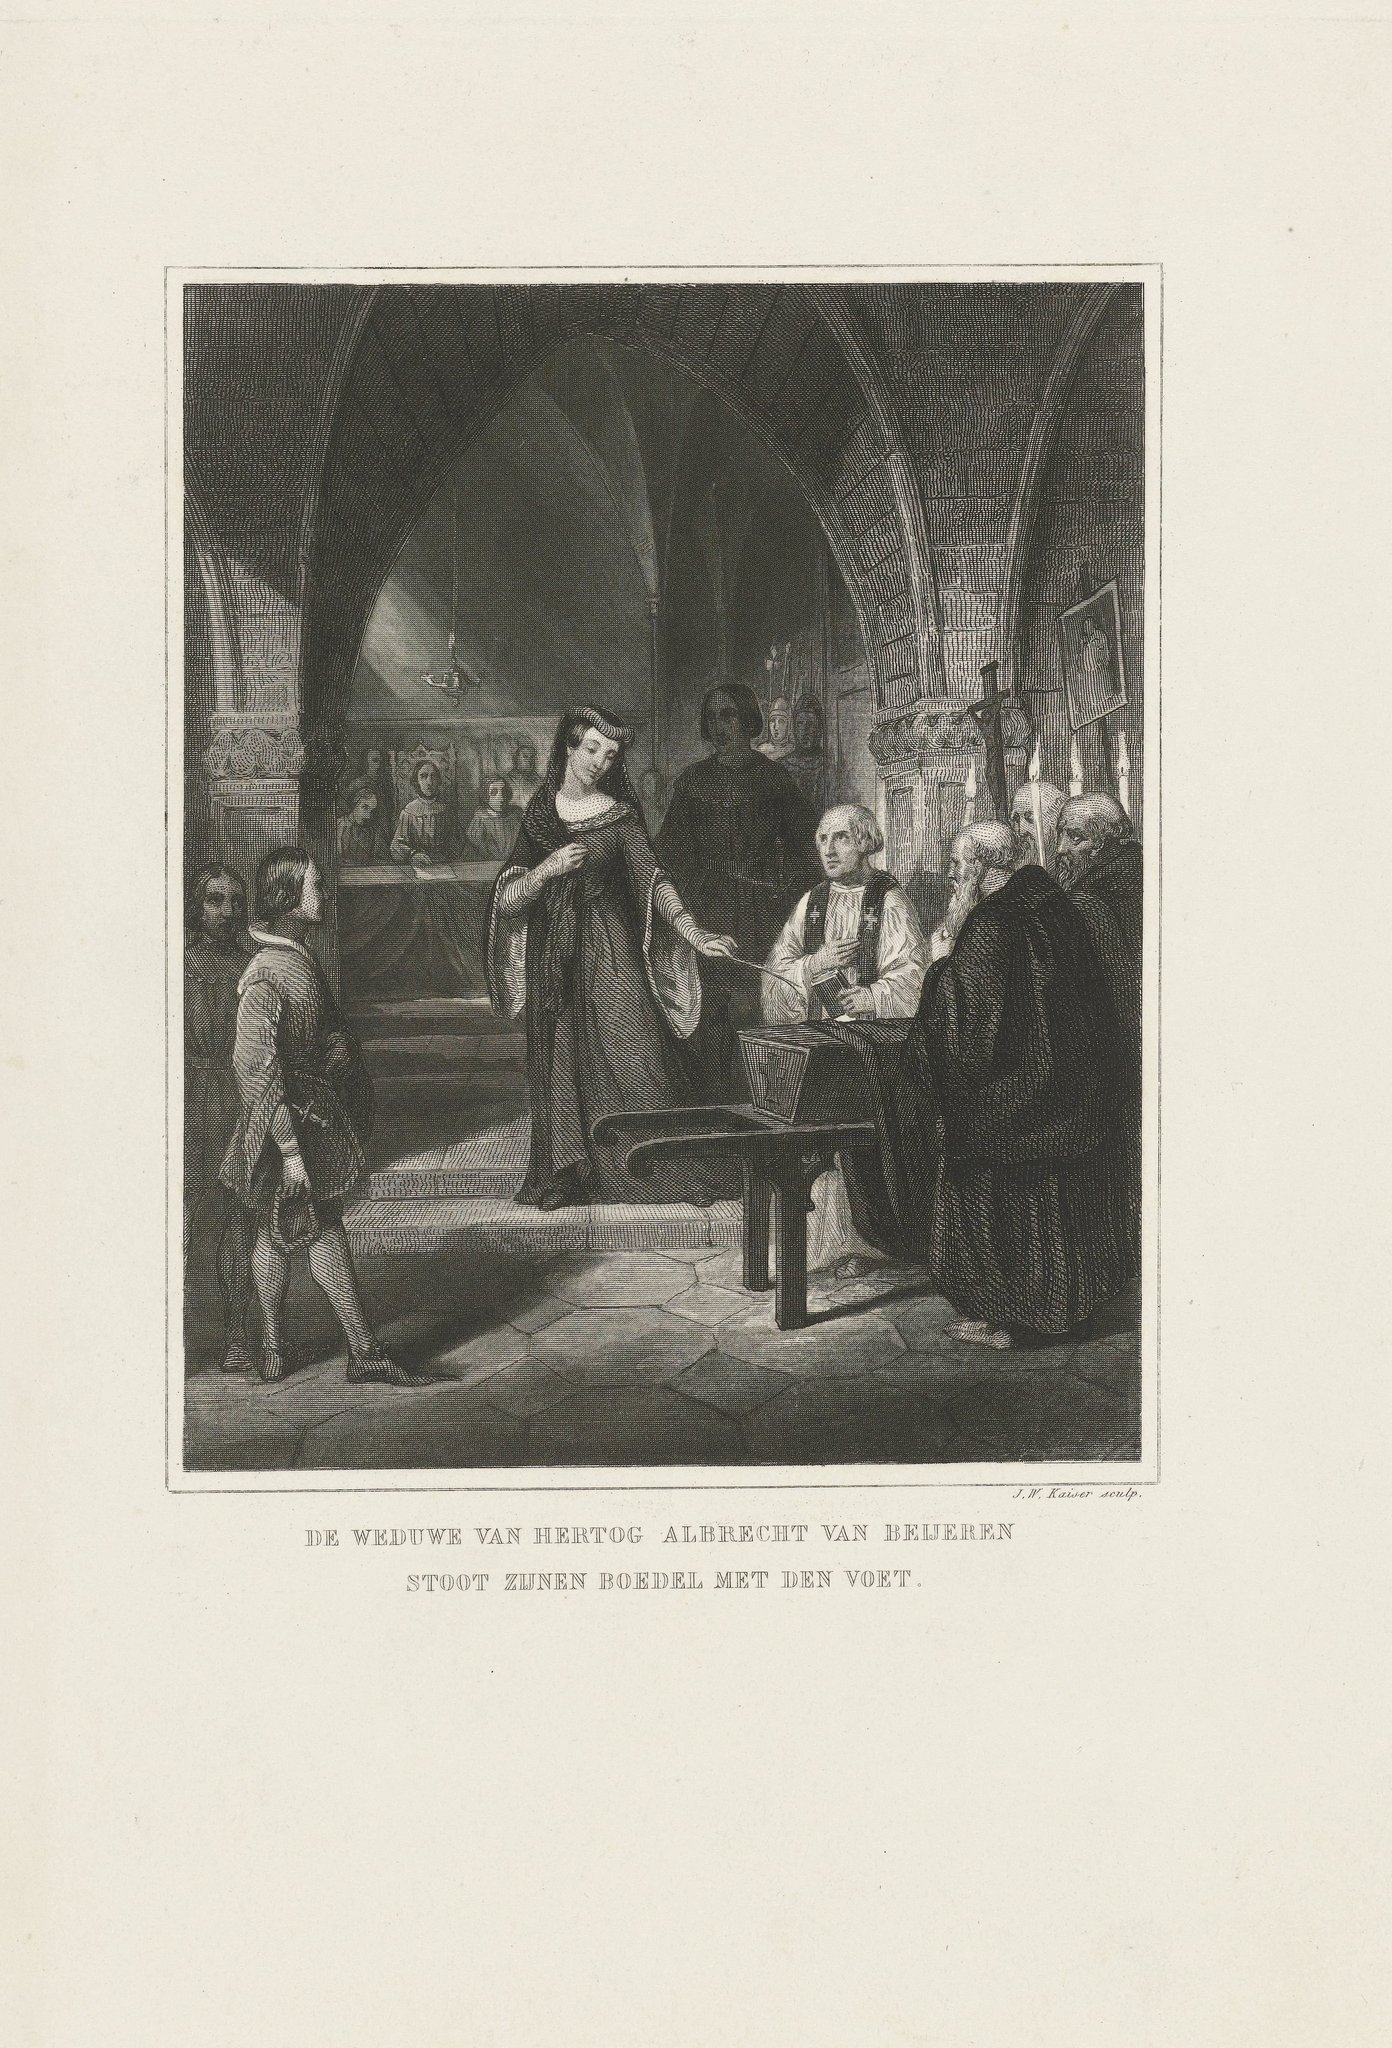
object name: print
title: De weduwe van hertog Albrecht van Beijeren stoot zijnen boedel met den voet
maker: johann wilhelm kaiser (i)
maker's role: draughtsman, print maker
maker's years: 1813-1900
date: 1840-1884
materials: paper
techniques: engraving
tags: the hague, duke of bavaria albert i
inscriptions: collector's mark: Lugt 2228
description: In een interieur staat de doodskist van Albrecht van Beieren. Zijn weduwe Margaretha van Kleef raakt, in het bijzijn van een aantal geestelijken, de kist aan met een takje. Hiermee doet ze afstand van de boedel en schuldenlast van haar echtgenoot. In het jaar 1405.